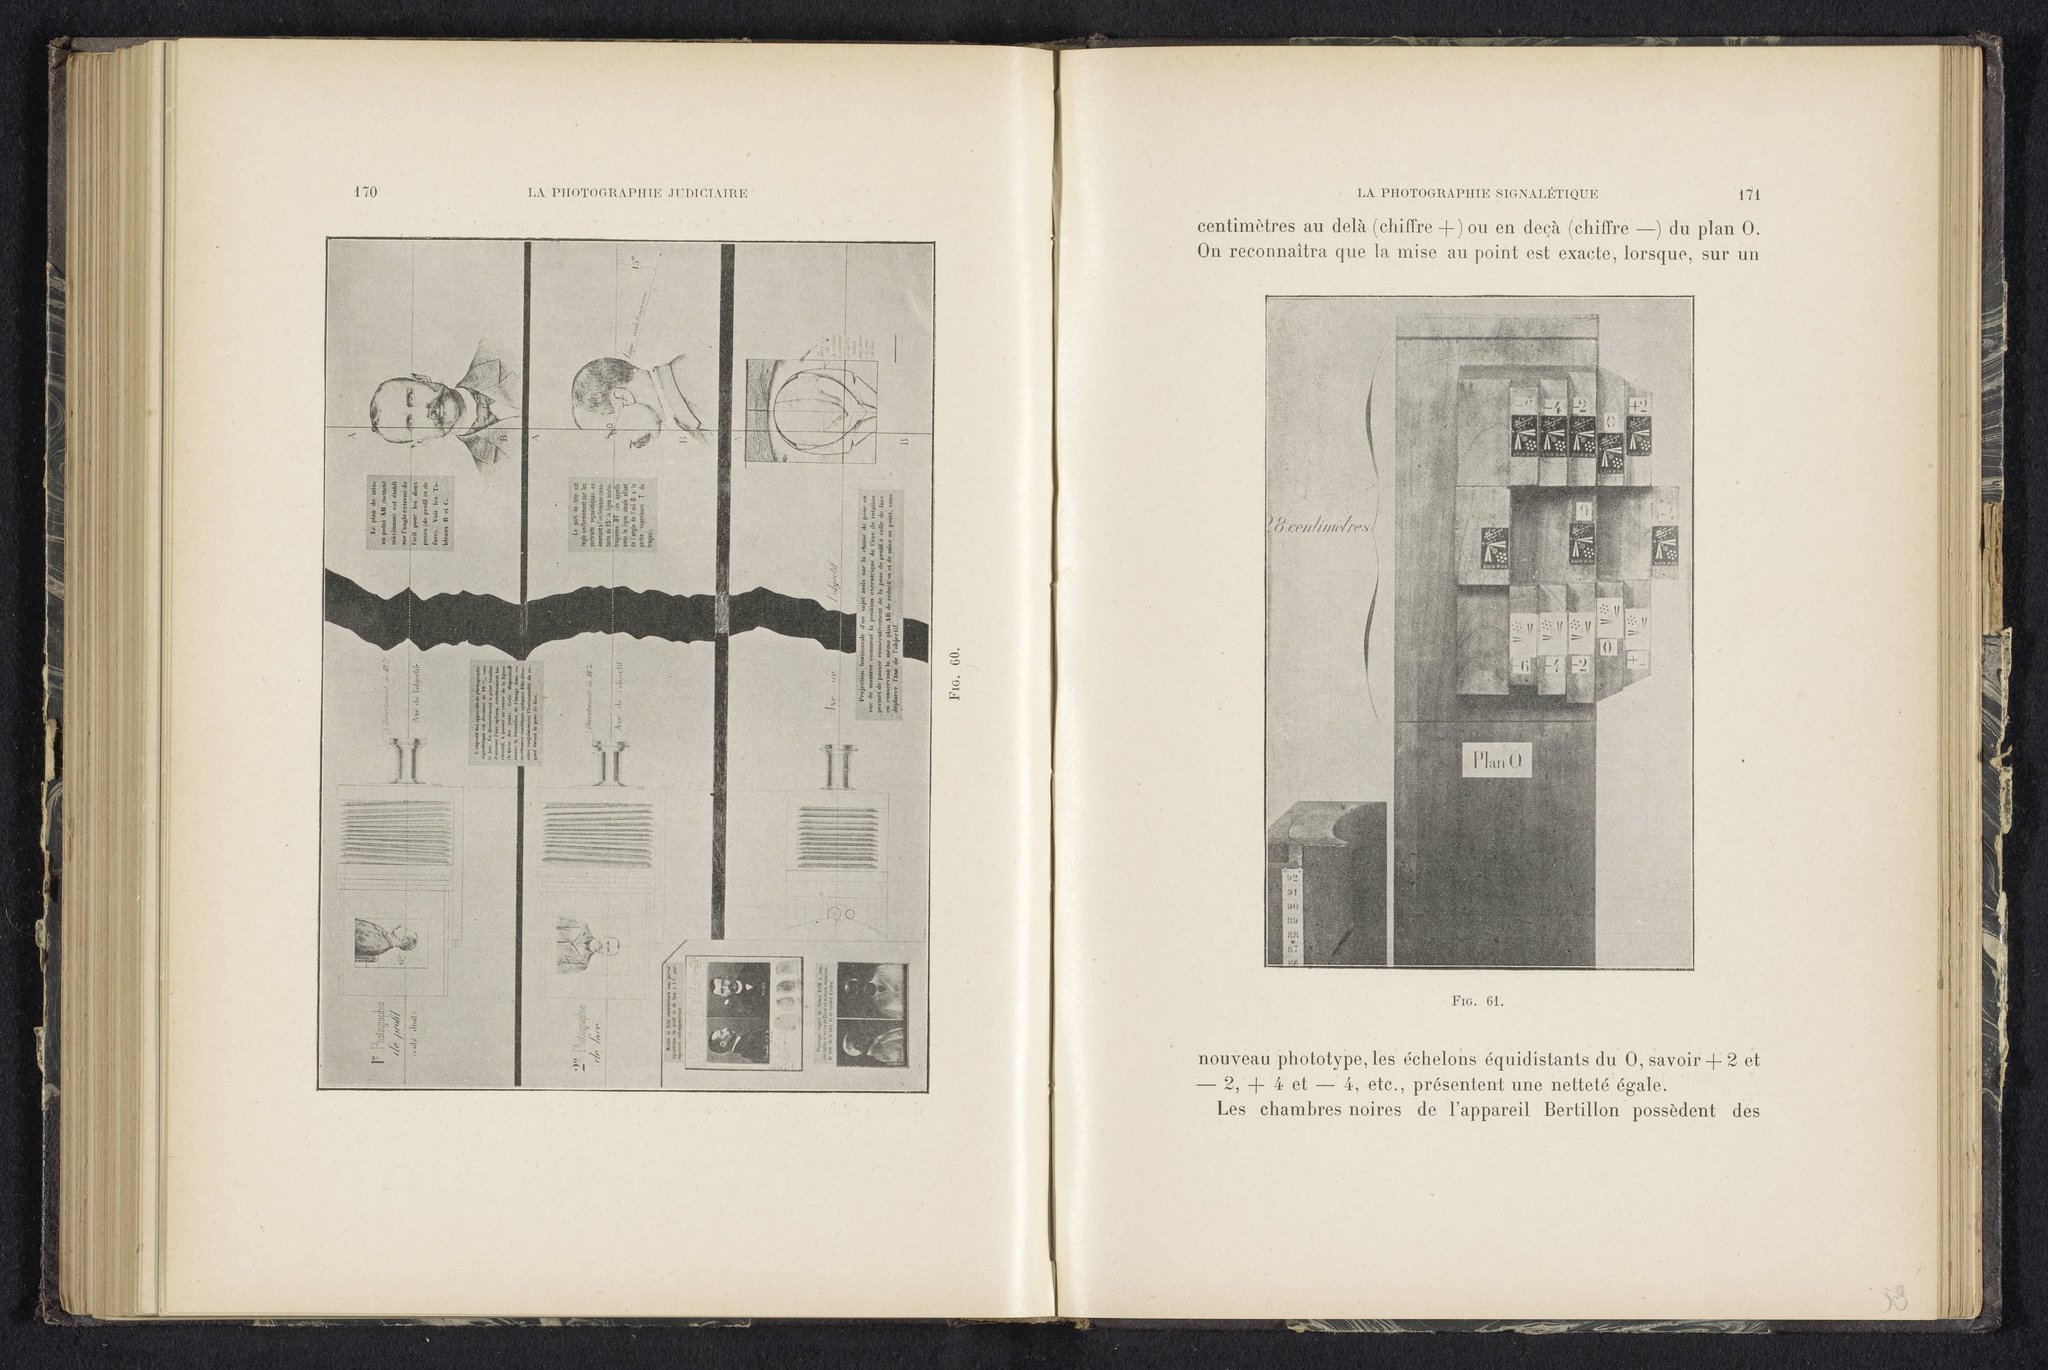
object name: photomechanical print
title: Aanwijzingen voor het fotograferen van criminelen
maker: Anonymous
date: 1893-1903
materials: paper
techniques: autotype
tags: photography, criminals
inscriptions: number: ‘Fig. 60.’